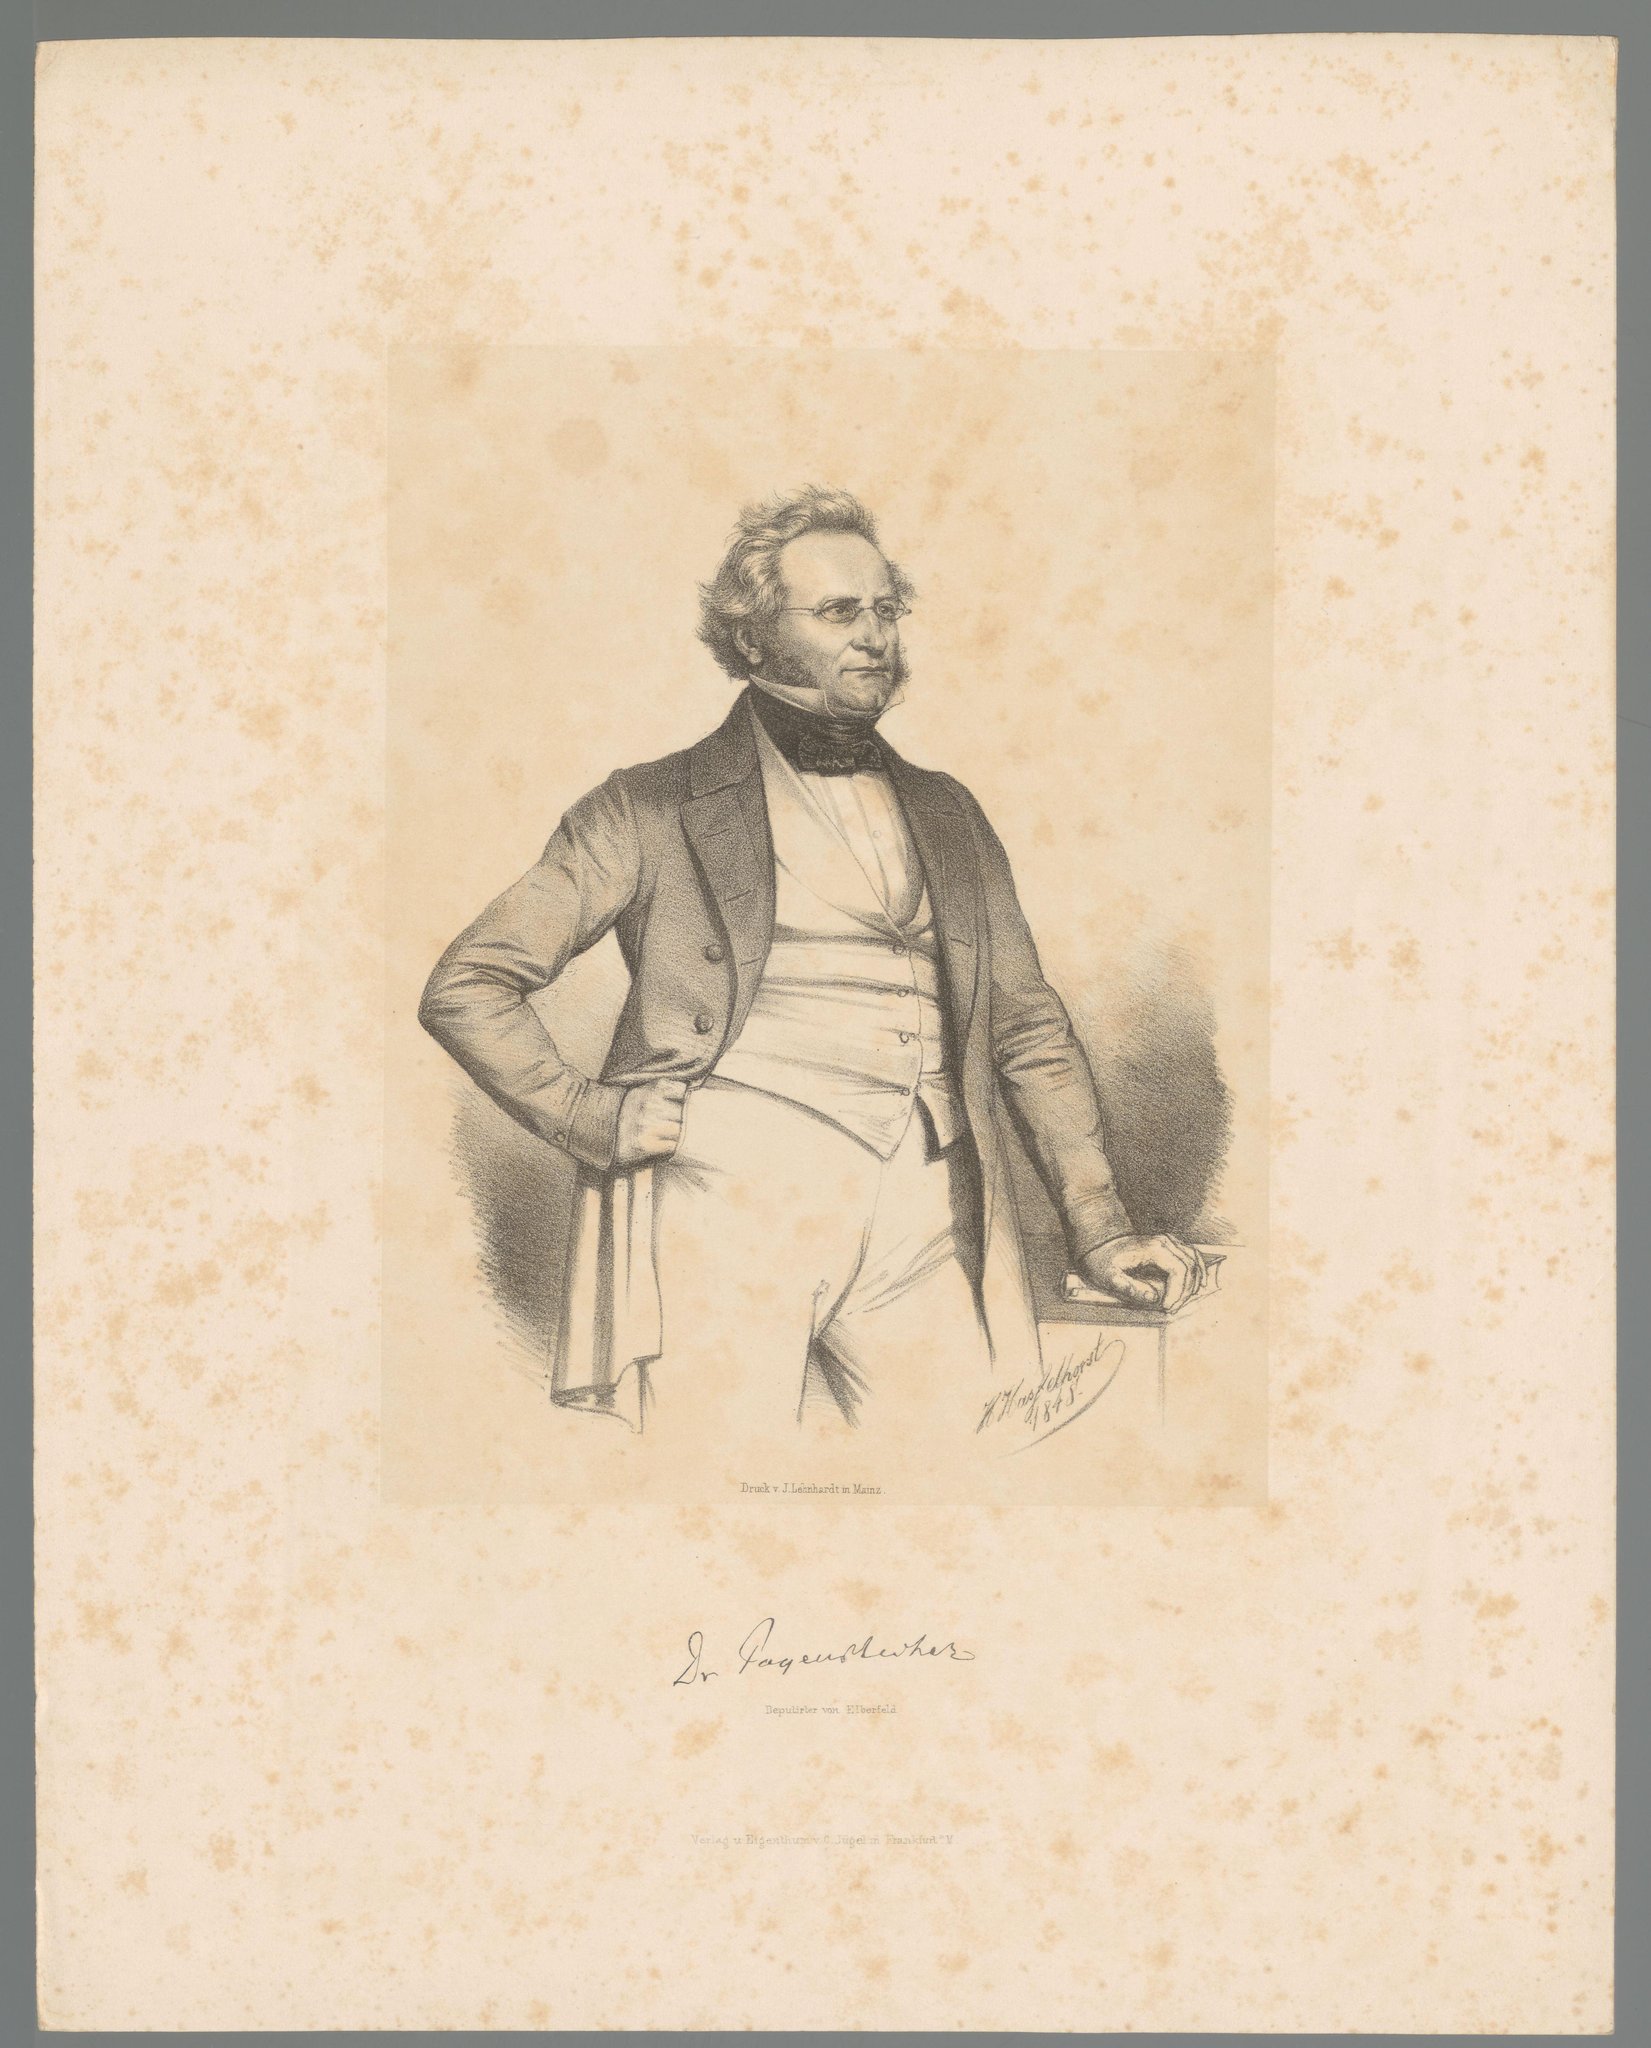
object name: print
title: Portret van Alexander Pagenstecher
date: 1848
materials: paper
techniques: lithograph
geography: frankfurt am main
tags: politician, historical persons, physician, doctor, politician, e.g. party leader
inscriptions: collector's mark: Lugt 2228